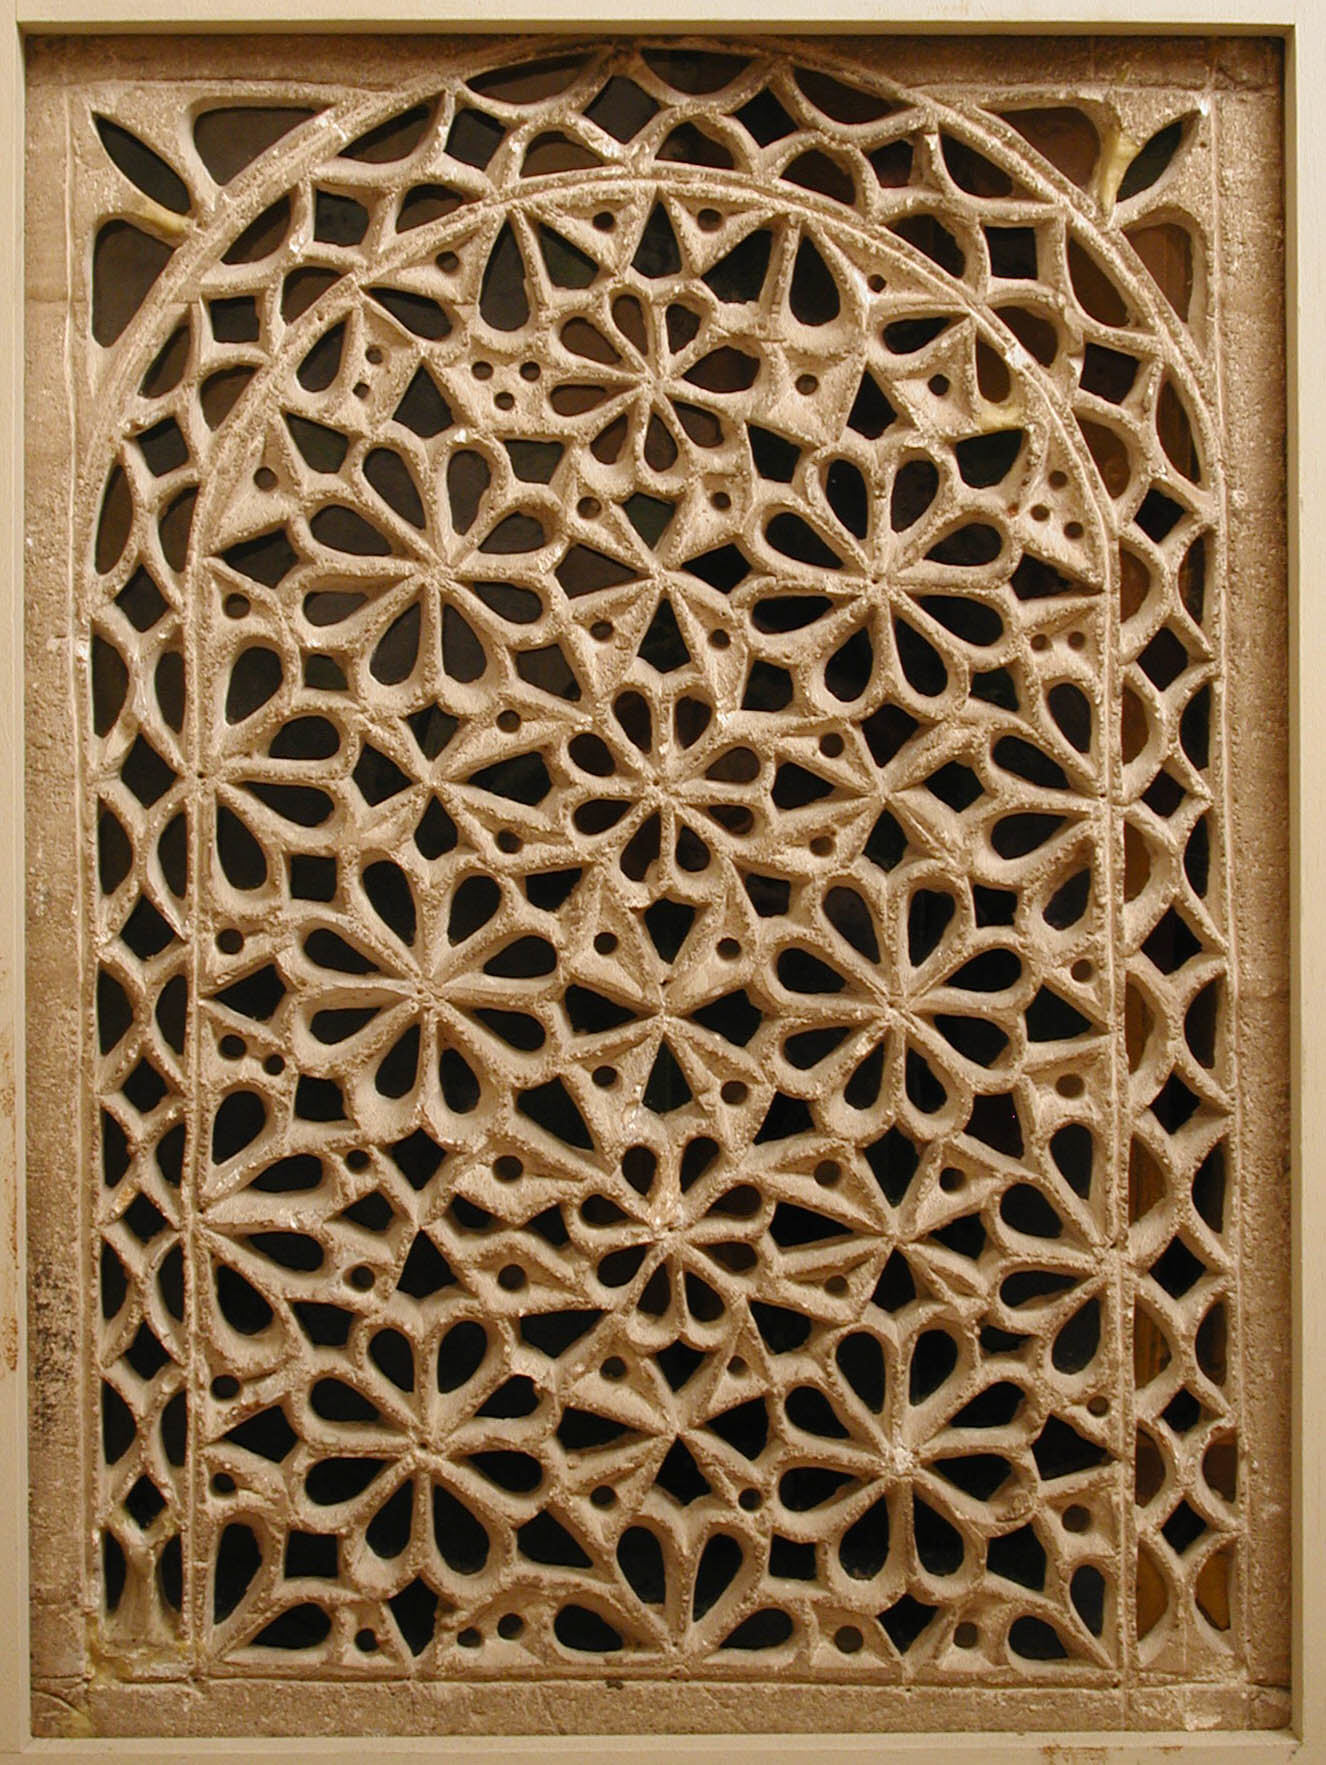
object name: window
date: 1601-1700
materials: gypsum, glass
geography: egypt or syria